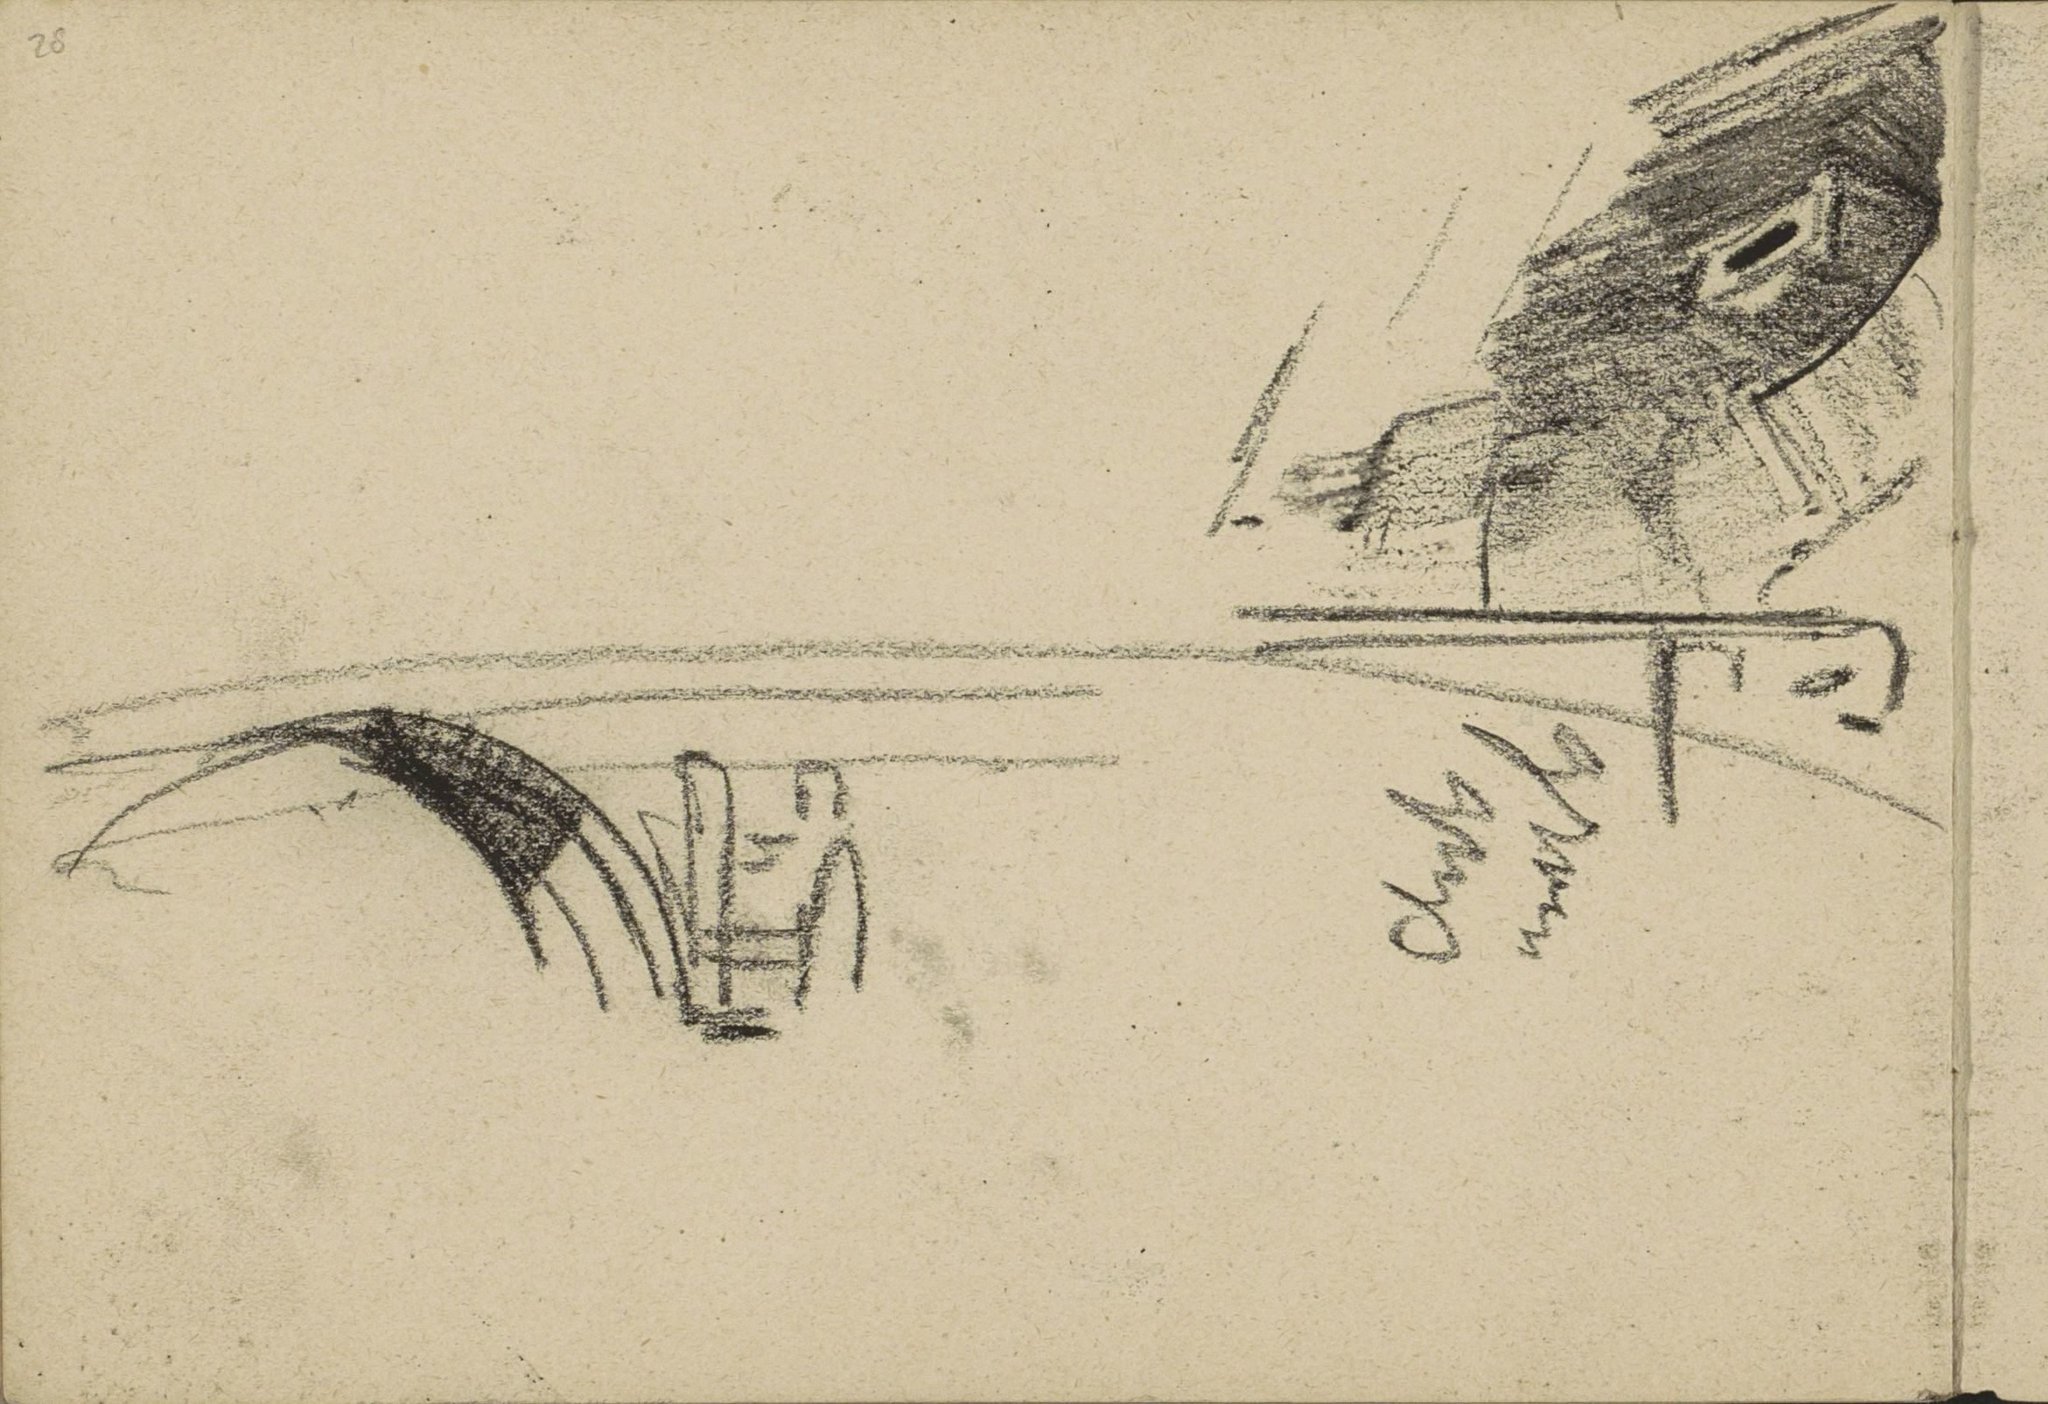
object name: sketchbook leaf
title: Gezicht op de brug Lekkeresluis te Amsterdam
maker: willem witsen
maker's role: draughtsman, painter, print maker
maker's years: 1860-1923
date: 1870-1923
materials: chalk, paper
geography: amsterdam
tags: bridge in city across river, canal, etc.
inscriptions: : ‘[...]’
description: Pagina 28 uit een schetsboek met 16 bladen.